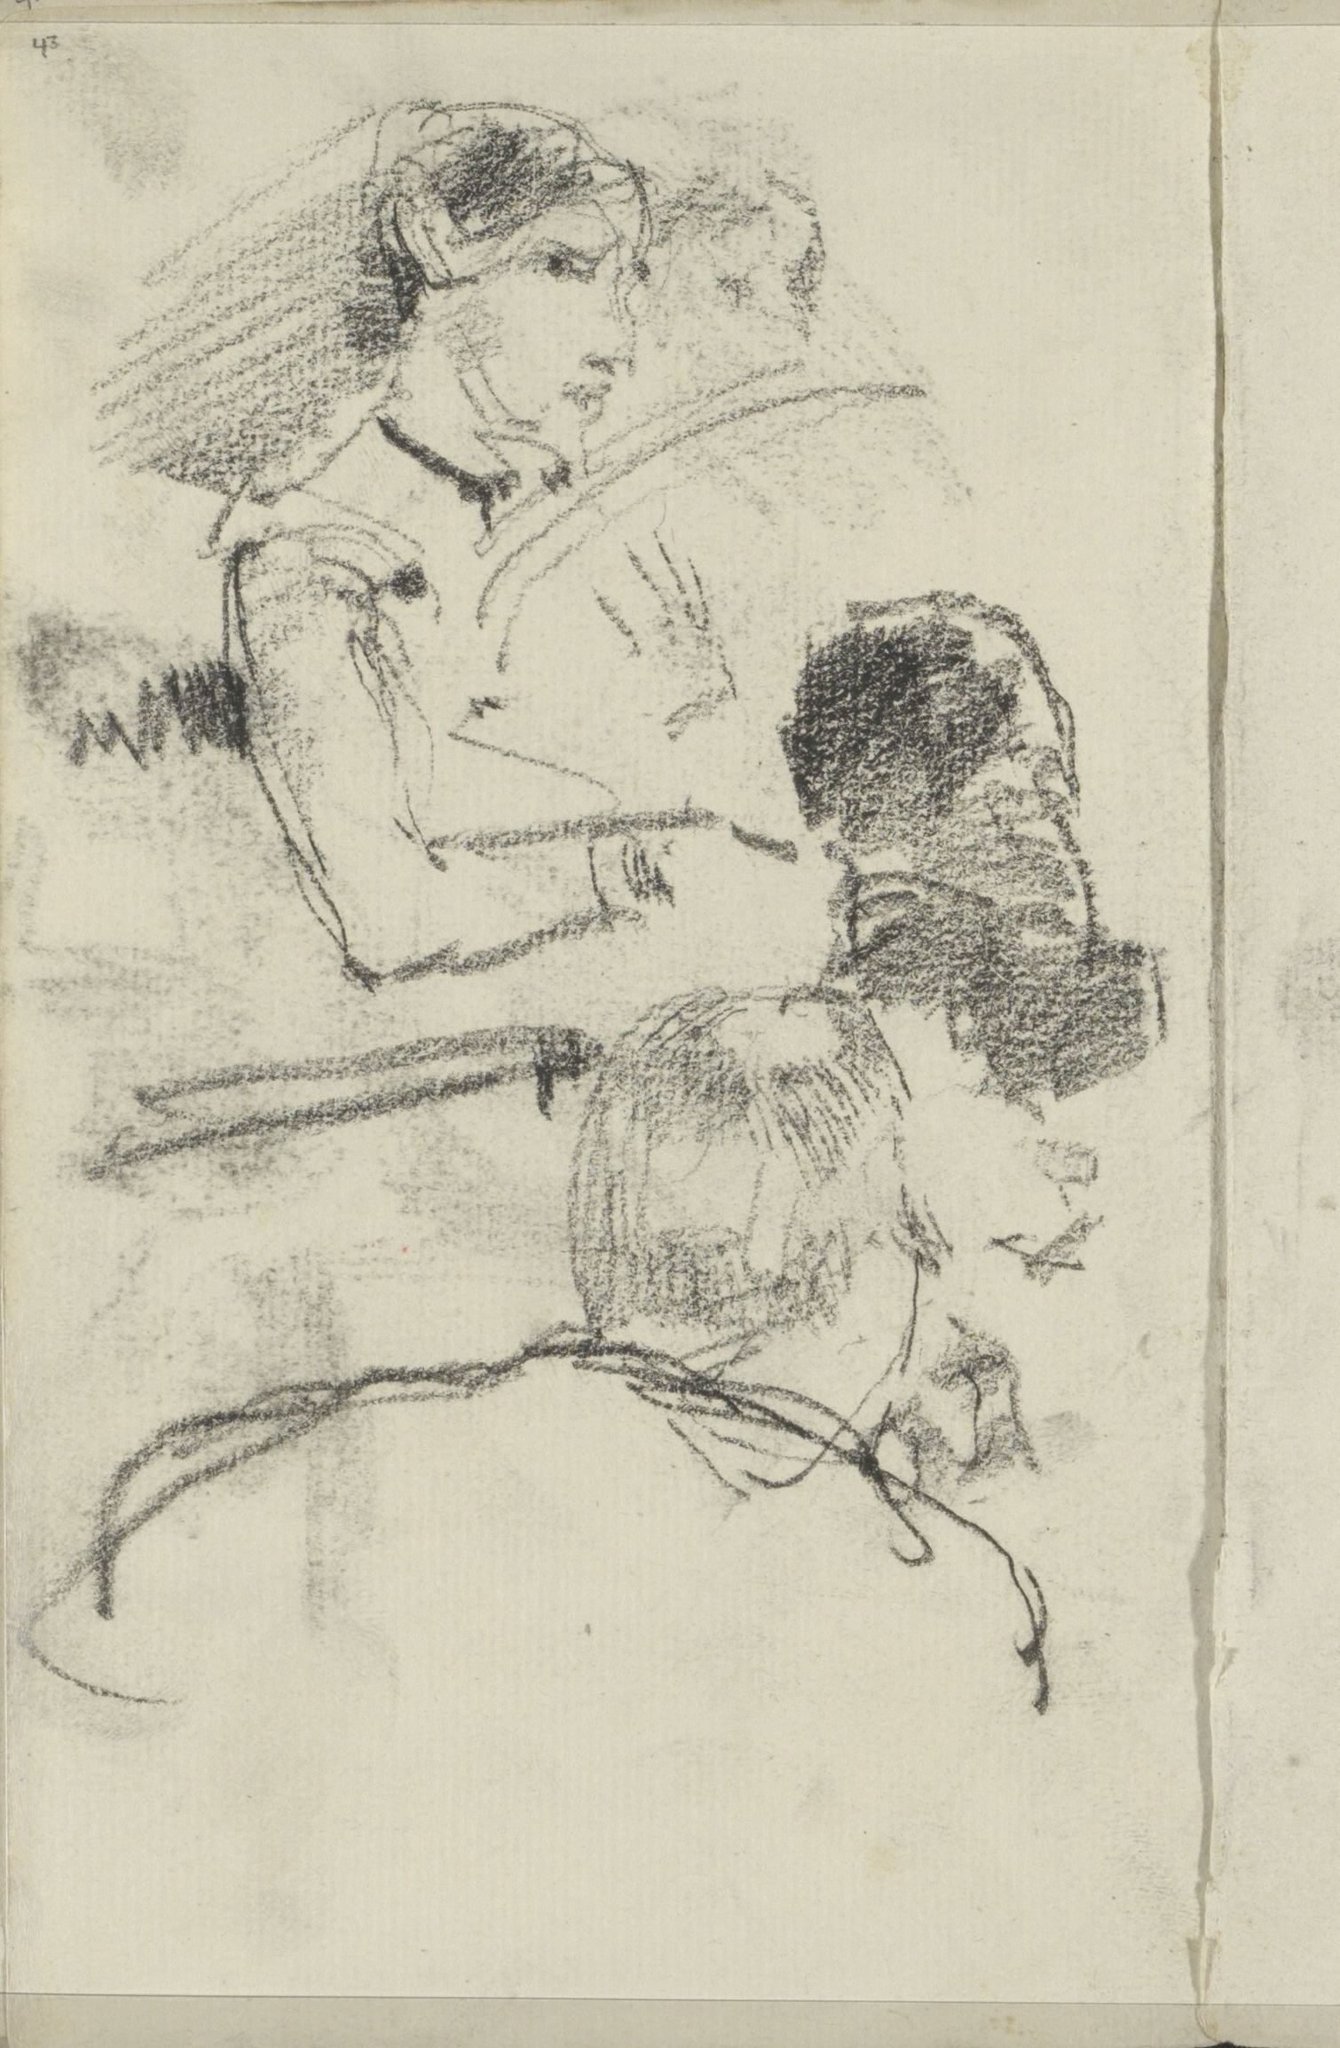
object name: sketchbook leaf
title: Studieblad met een vrouw en twee mannen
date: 1882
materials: chalk, paper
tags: adult woman, head (human) (+ back view)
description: Pagina 43 uit een schetsboek met 31 bladen vervaardigd te Den Haag en Rotterdam.